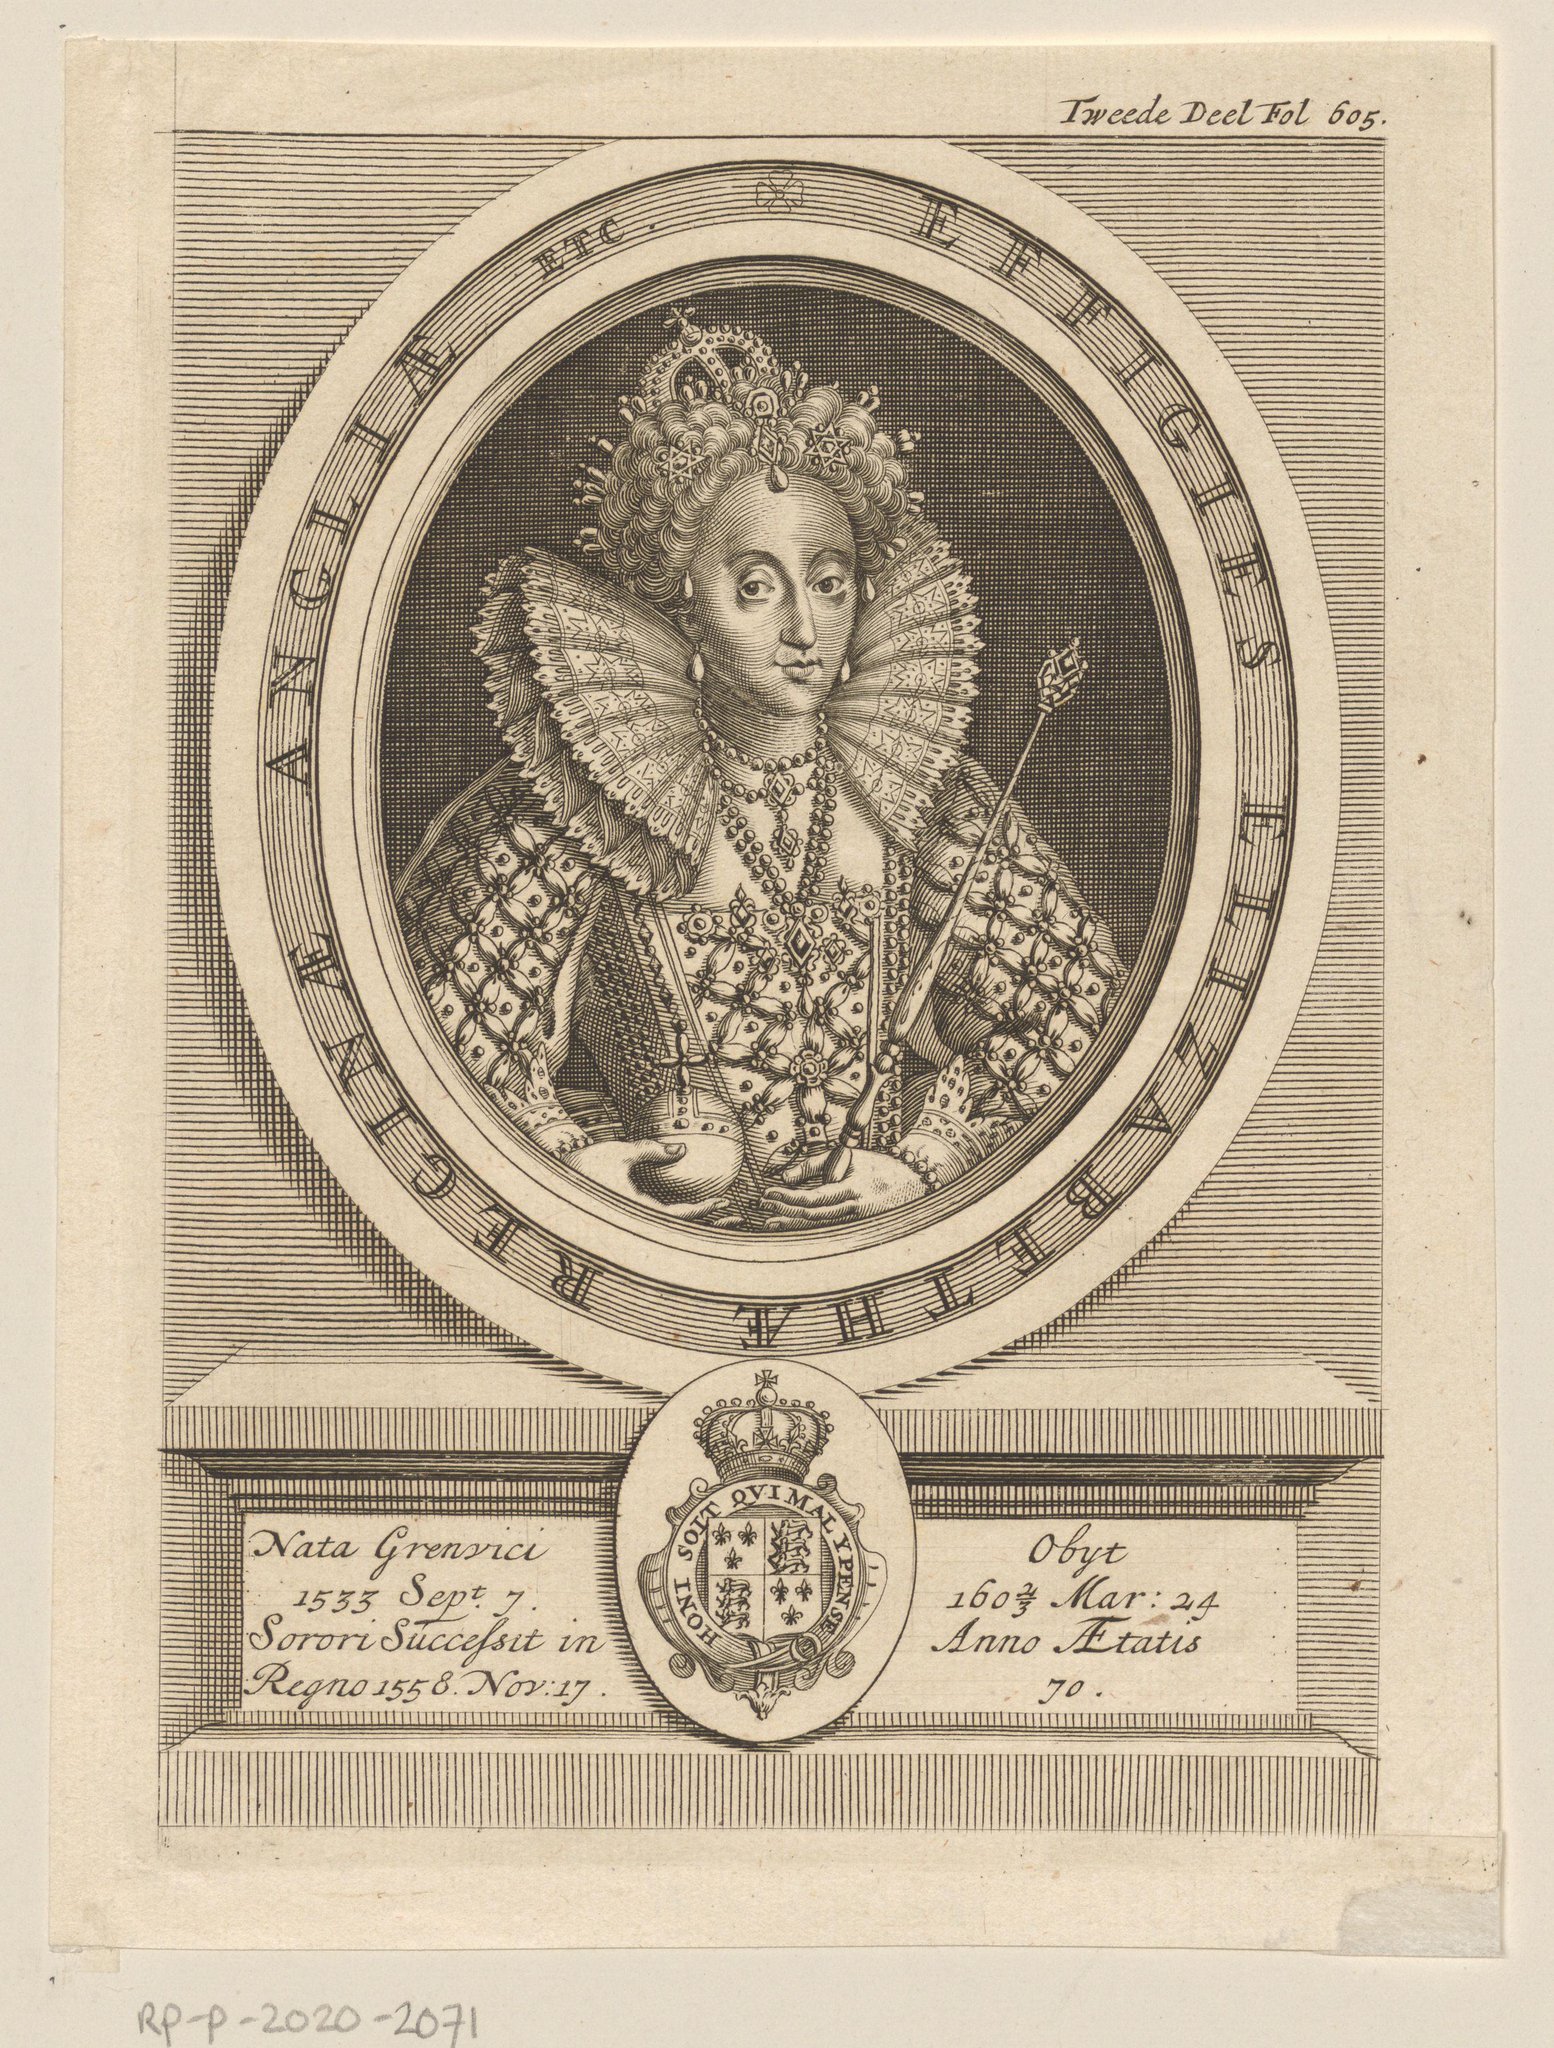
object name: print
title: Portret van Elizabeth I Tudor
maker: Anonymous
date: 1730-1790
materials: paper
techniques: engraving, etching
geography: northern netherlands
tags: historical persons - bb - woman, queen, pearl; pearl necklace, crown (symbol of sovereignty) - bb - female ruler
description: Prent komt uit een onbekende publicatie.